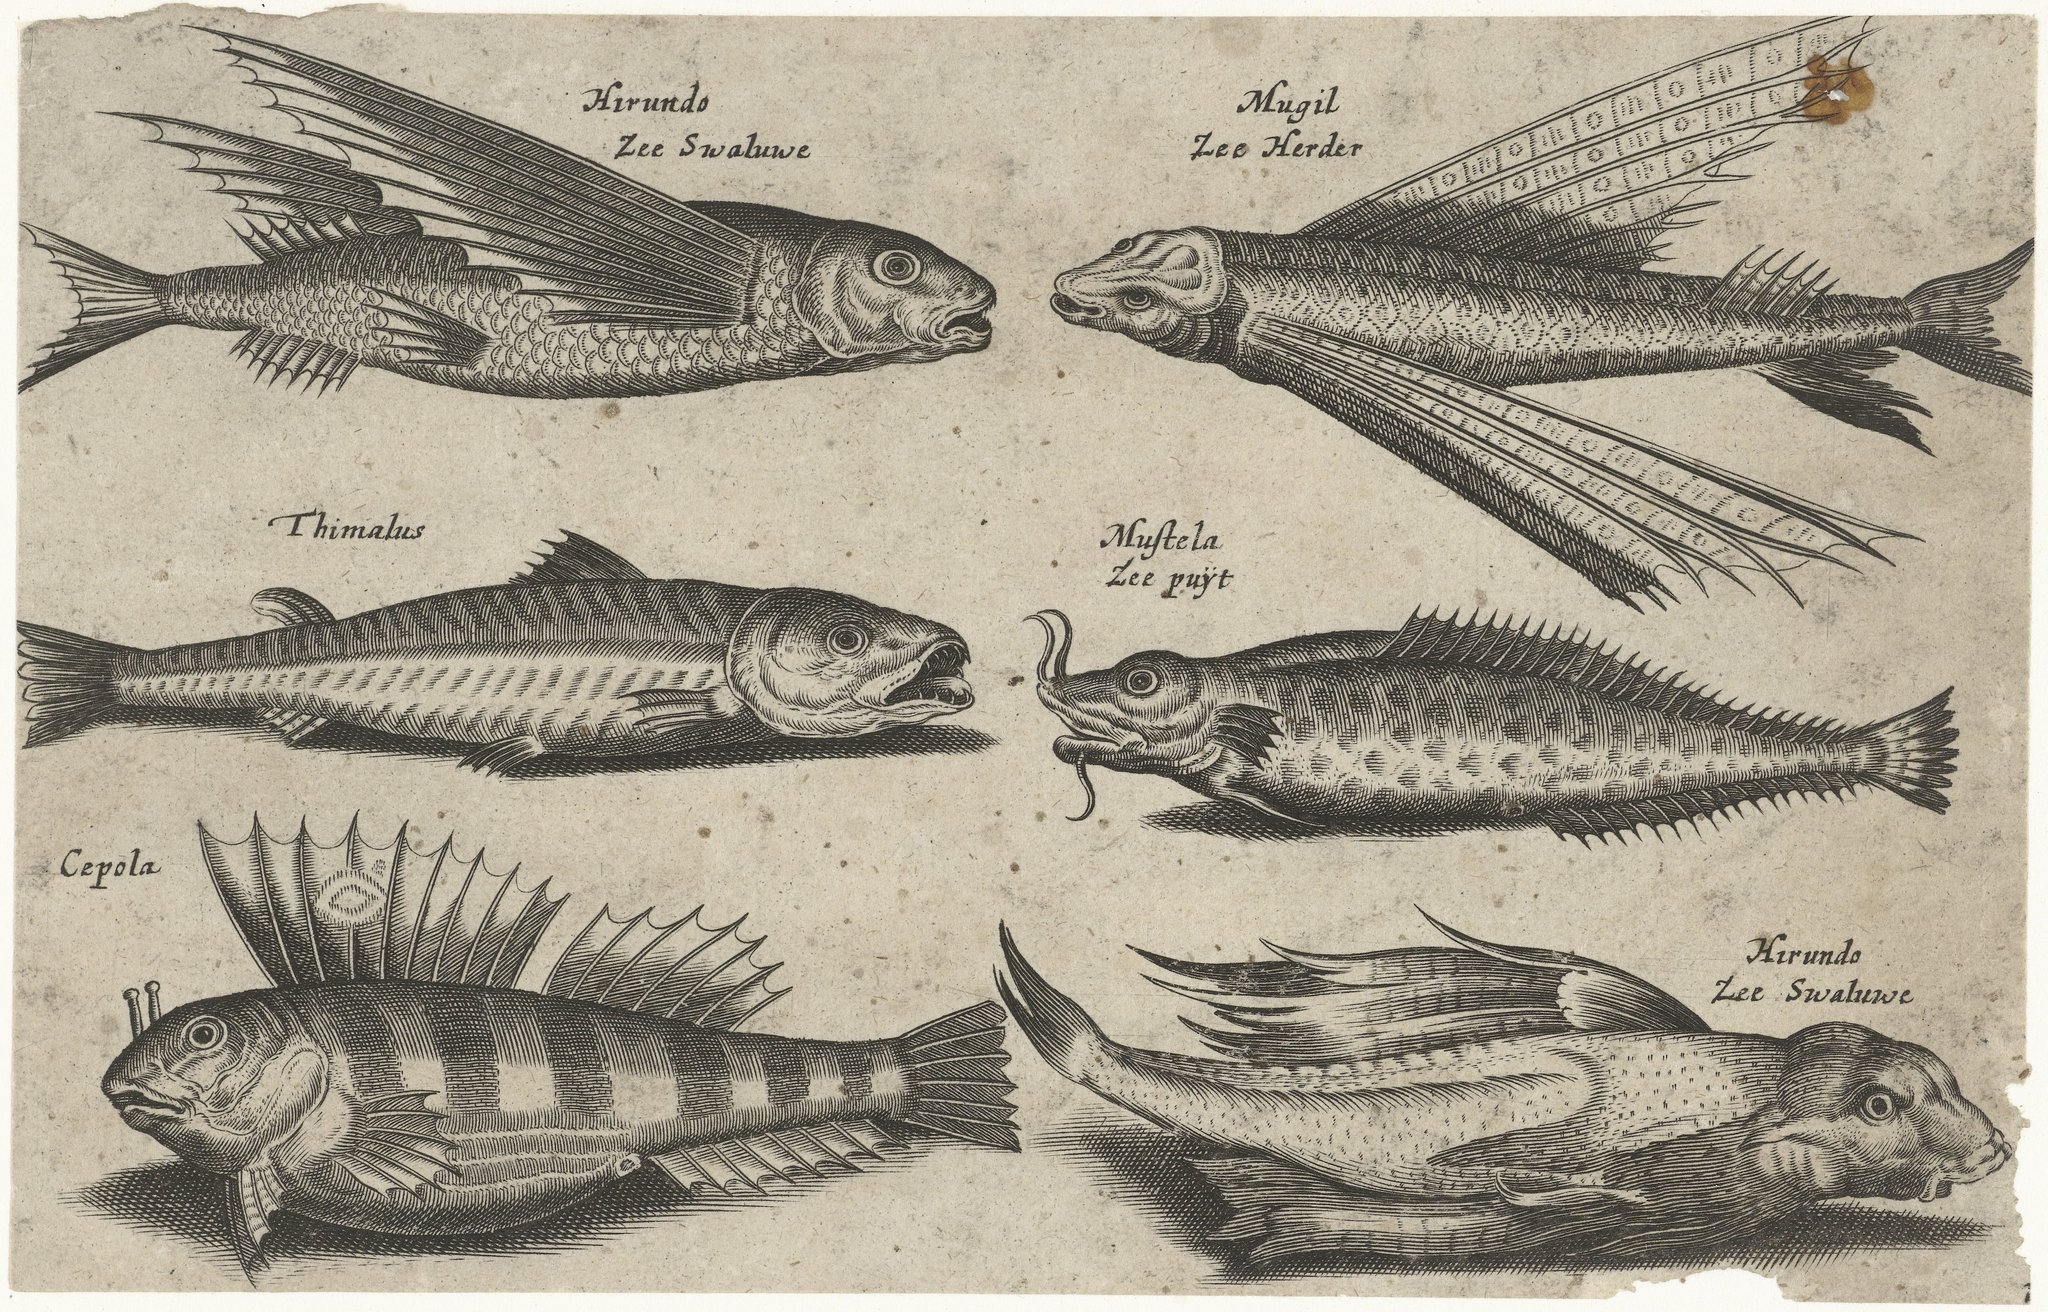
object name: print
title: Piscivm vivae icones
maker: pierre firens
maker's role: print maker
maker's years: 1580-1638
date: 1600-1638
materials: paper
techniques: engraving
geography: paris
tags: fishes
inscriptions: collector's mark: Lugt 2228